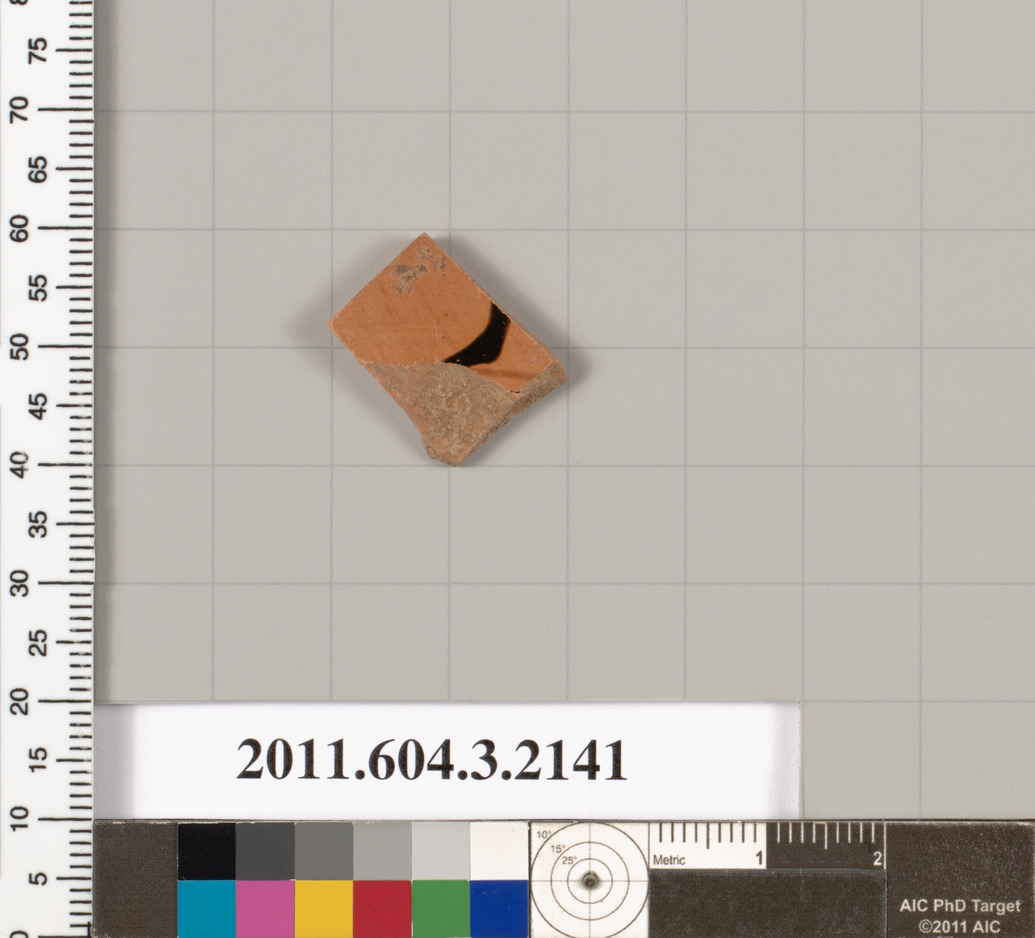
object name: kylix fragment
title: Terracotta fragment of a kylix (drinking cup)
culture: greek, attic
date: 534-468 BCE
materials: terracotta